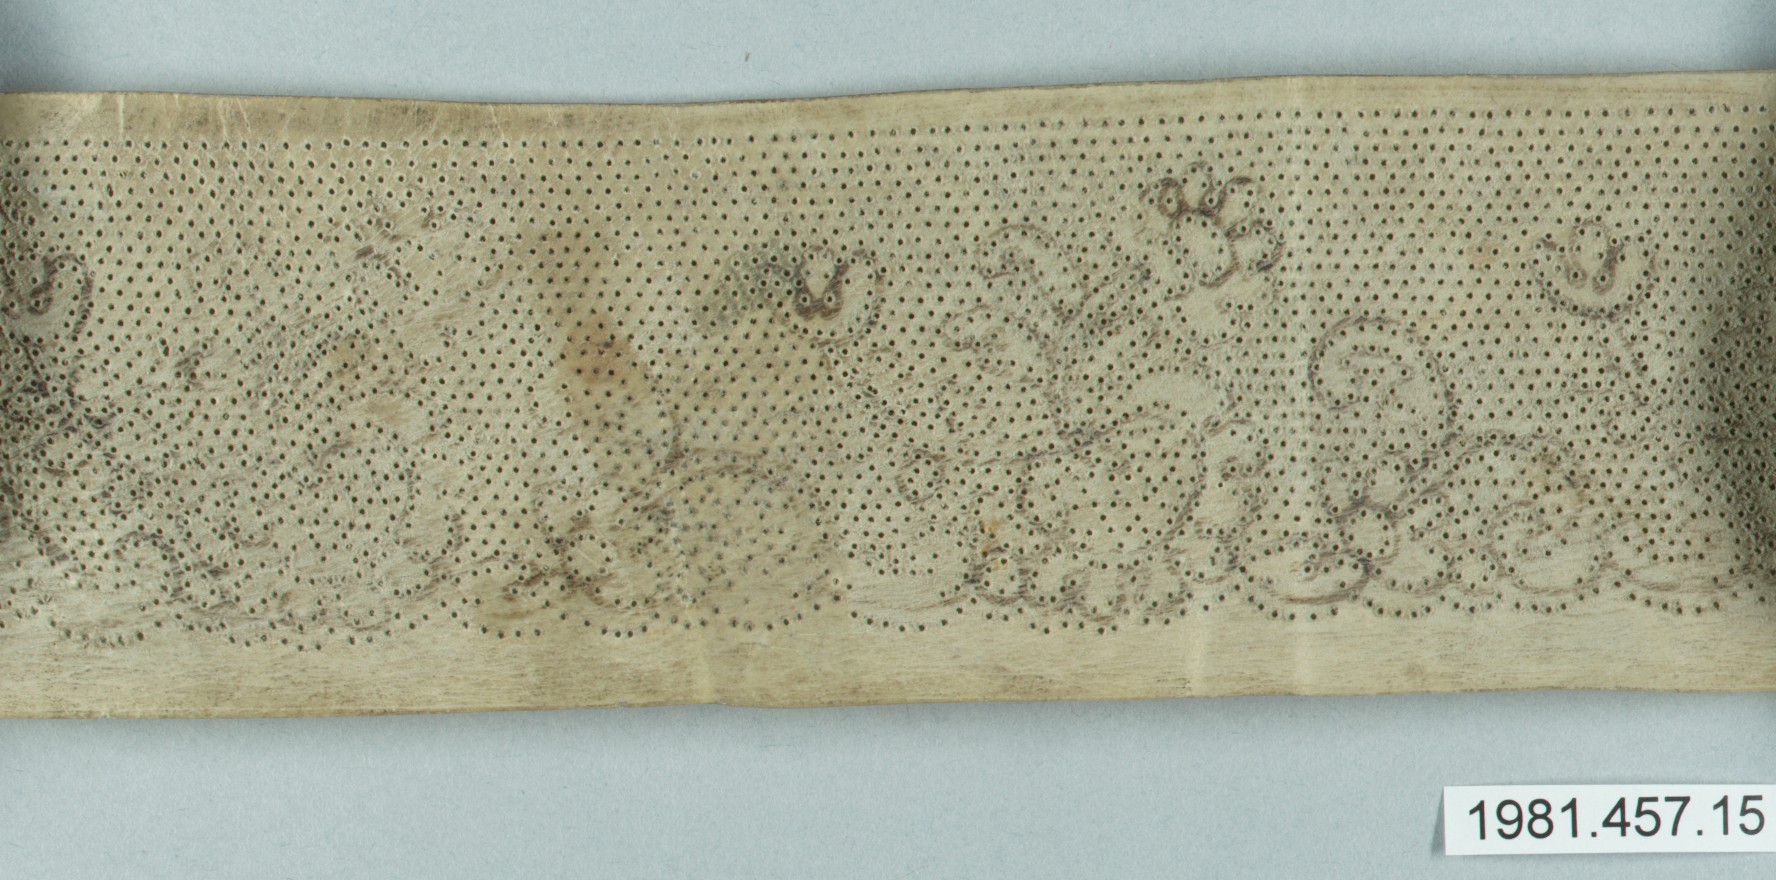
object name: pattern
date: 1840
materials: parchment